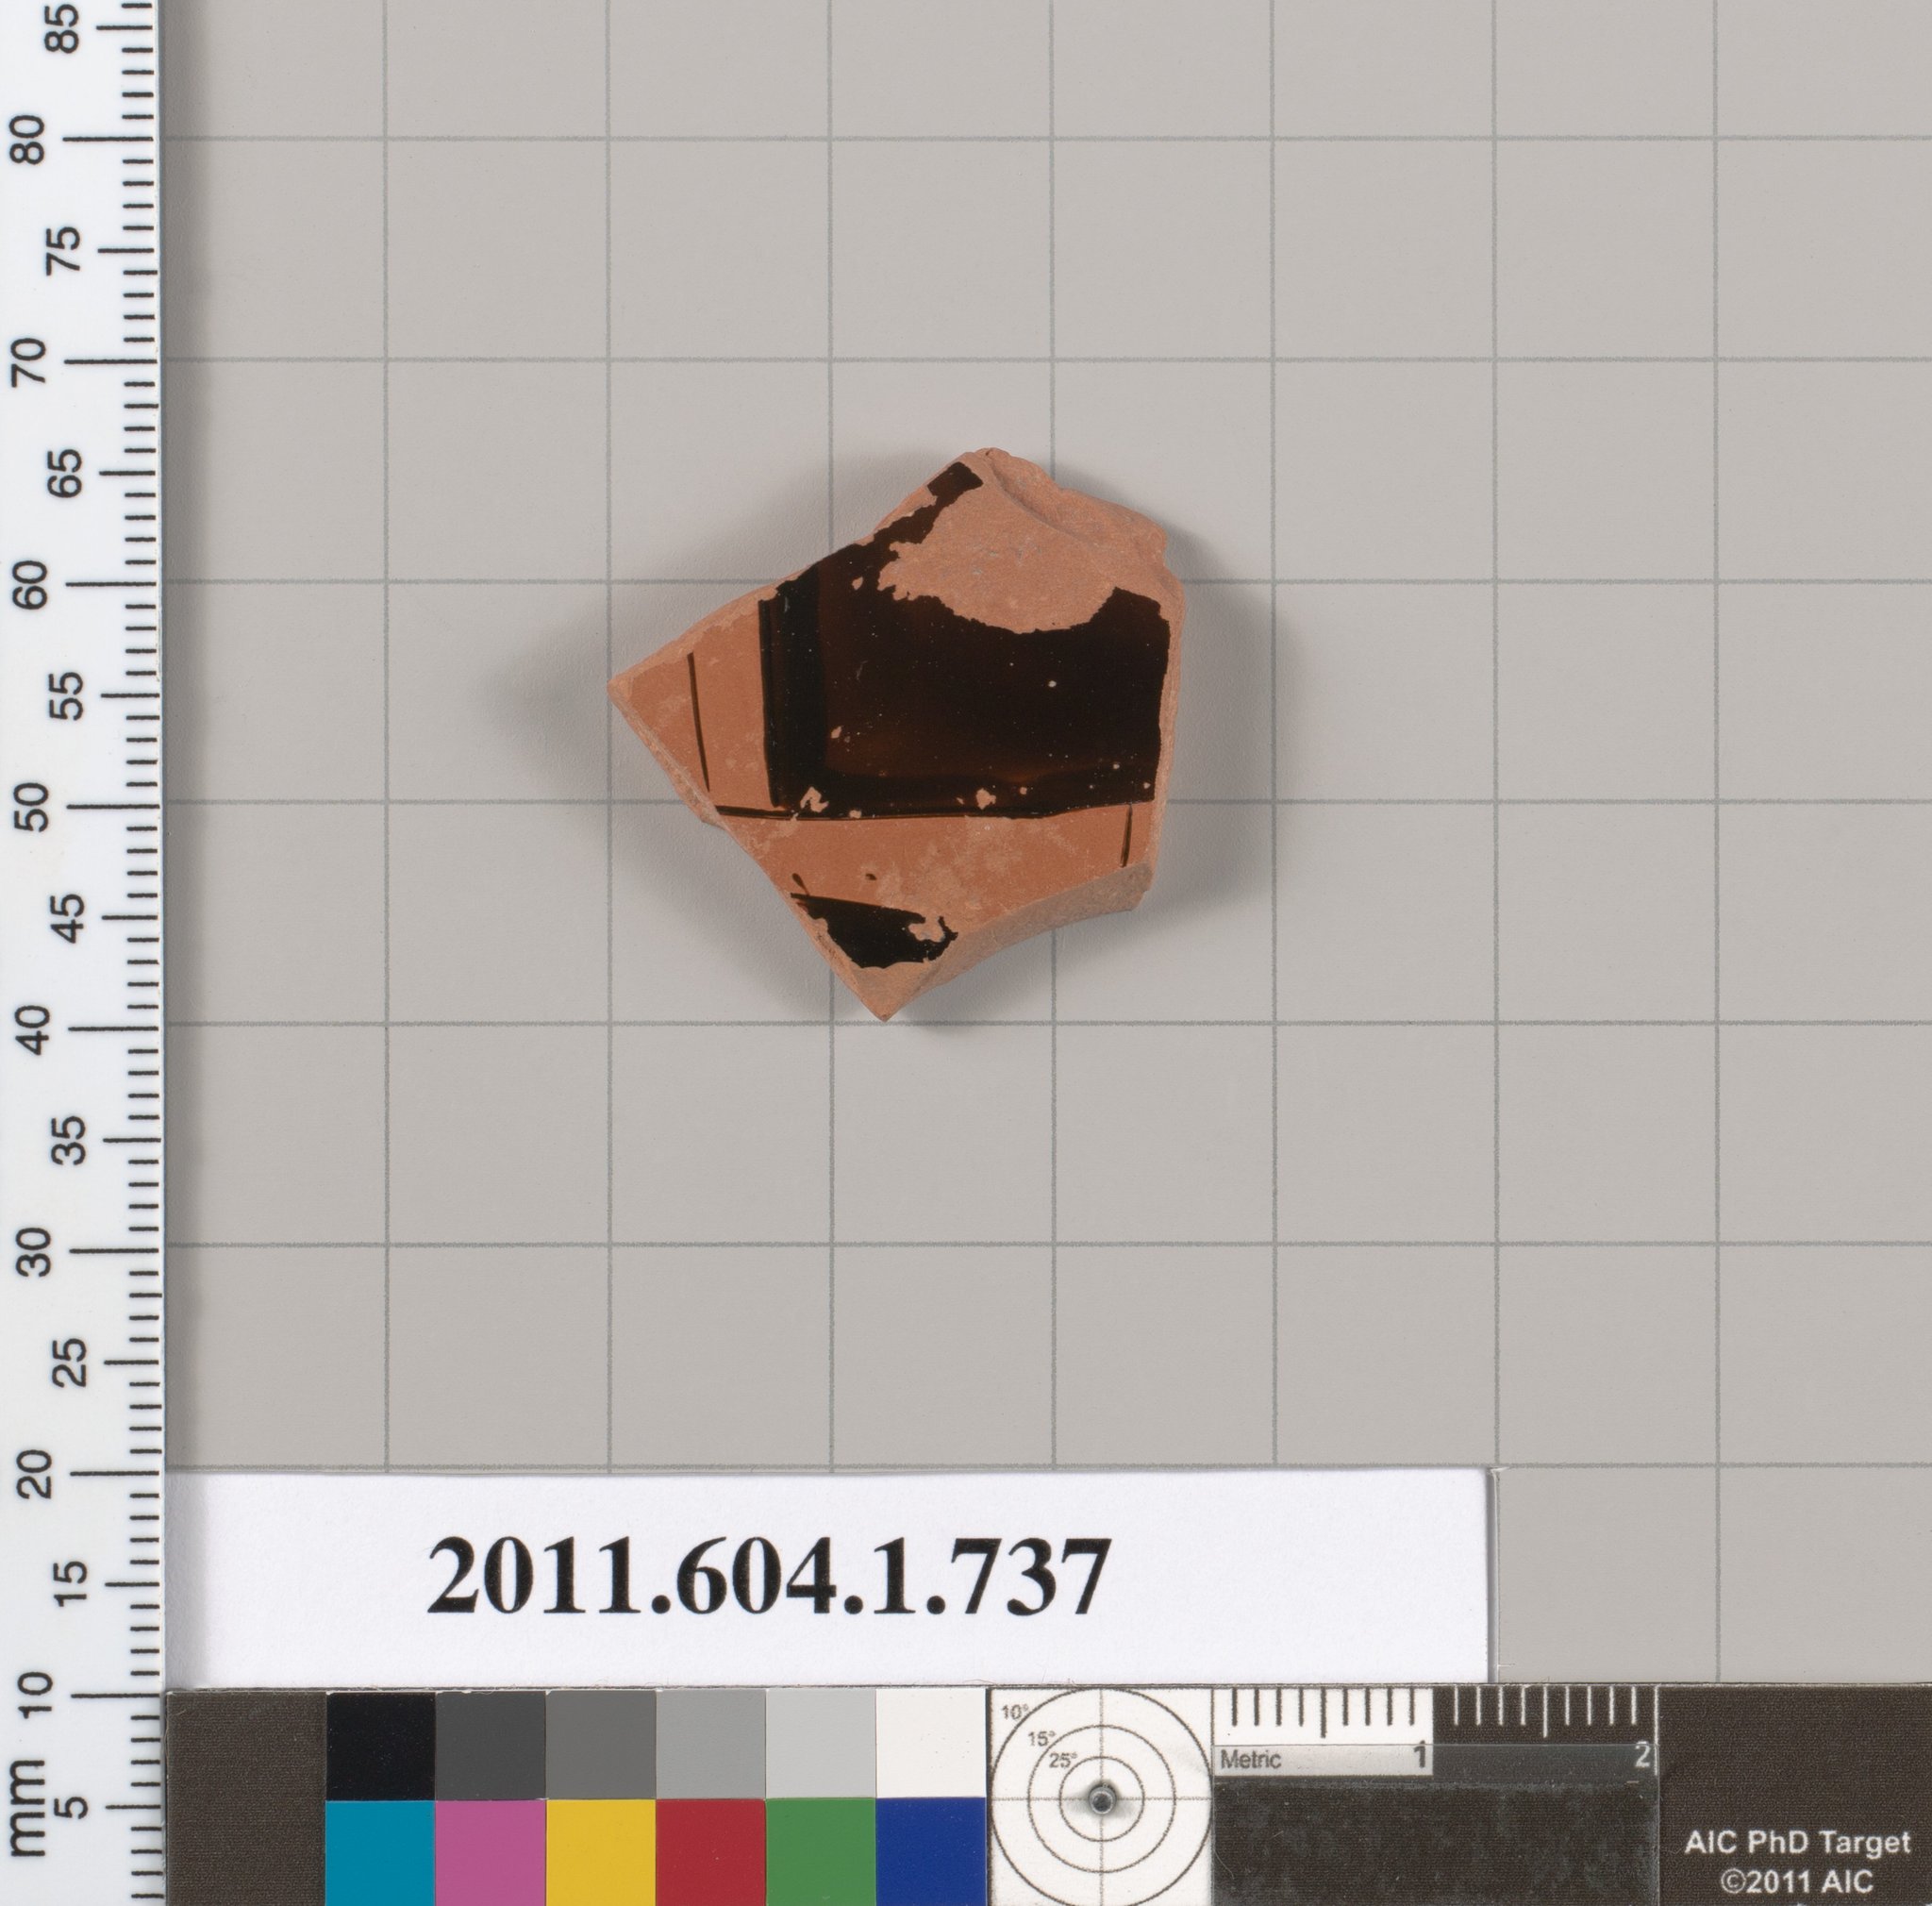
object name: kylix fragment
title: Terracotta fragment of a kylix (drinking cup)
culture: greek, attic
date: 475-451 BCE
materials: terracotta